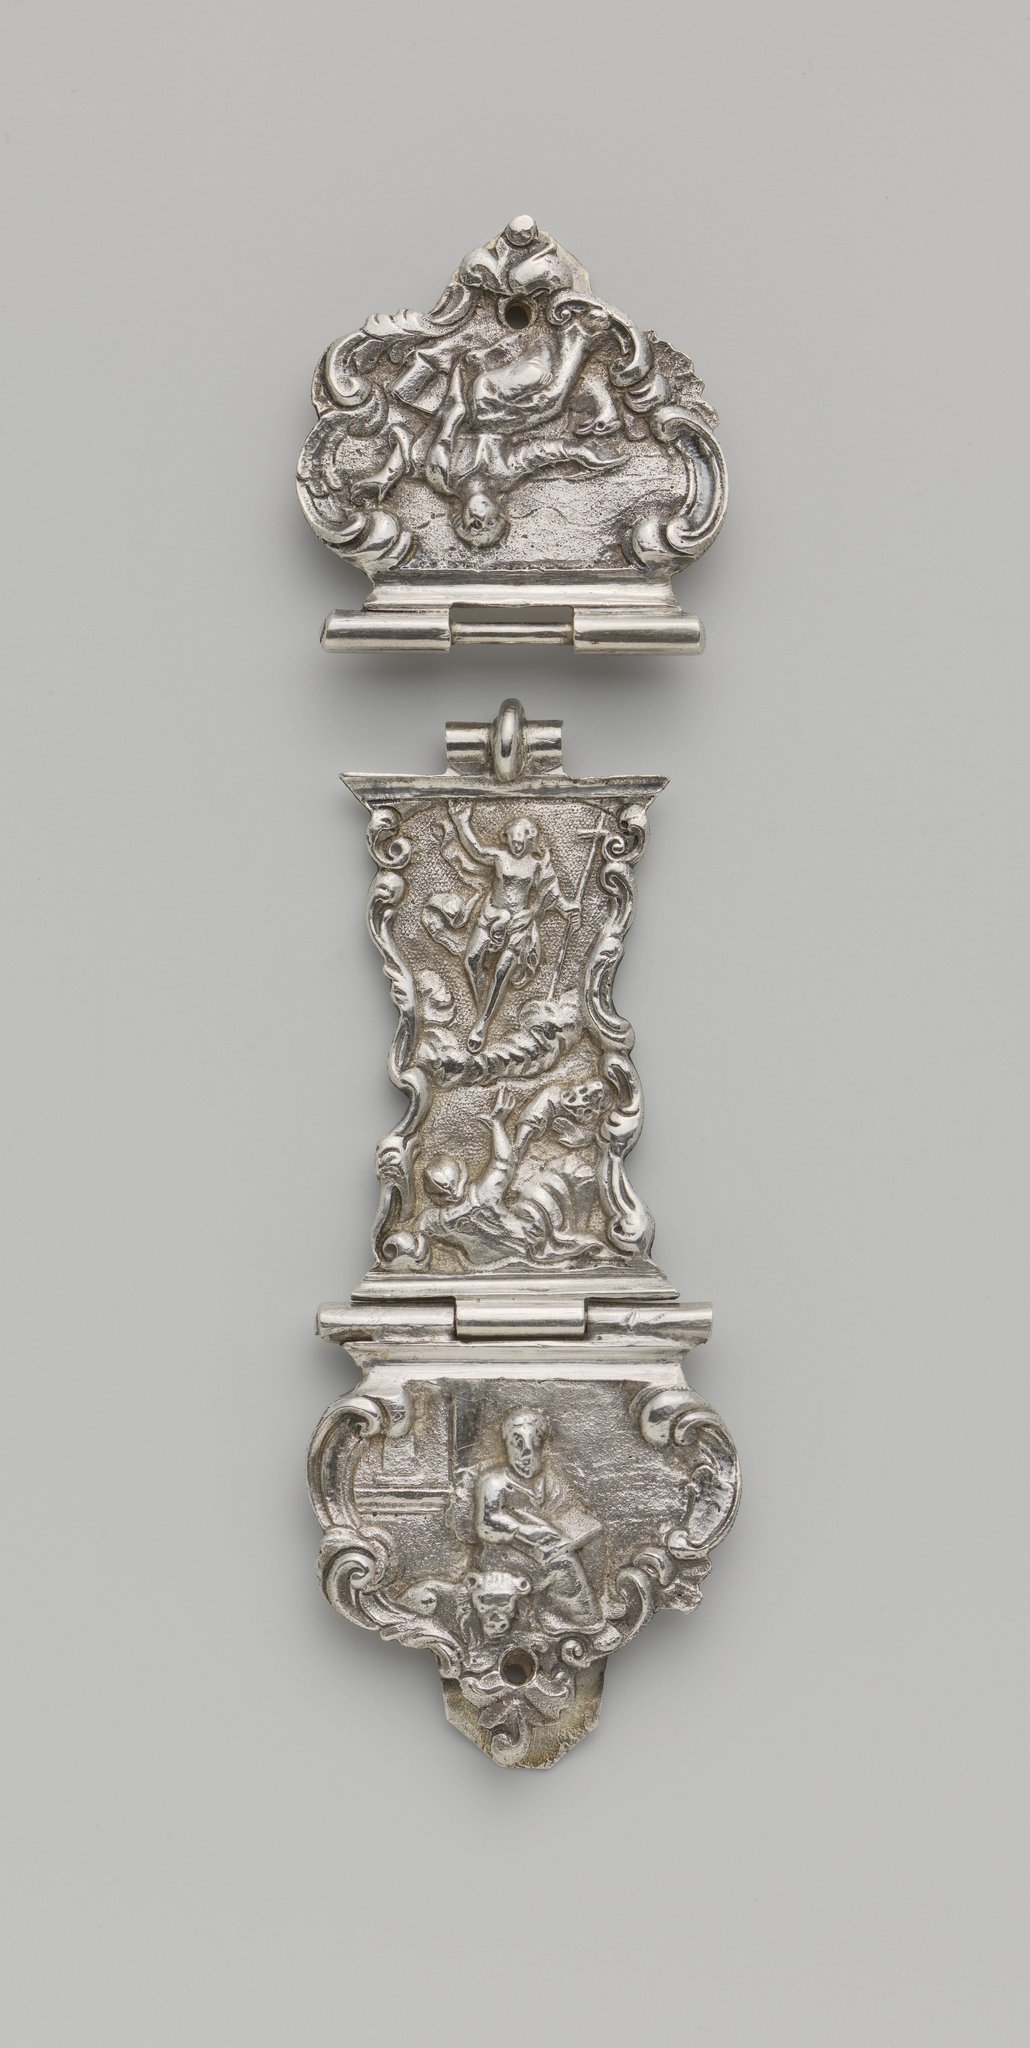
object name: boekslot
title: Boekslot met de verrijzenis van Maria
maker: Anonymous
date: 1810-1812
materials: silver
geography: hoorn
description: Boekslot van zilver, met de verrijzenis van Maria. In de hoeken twee evangelisten.